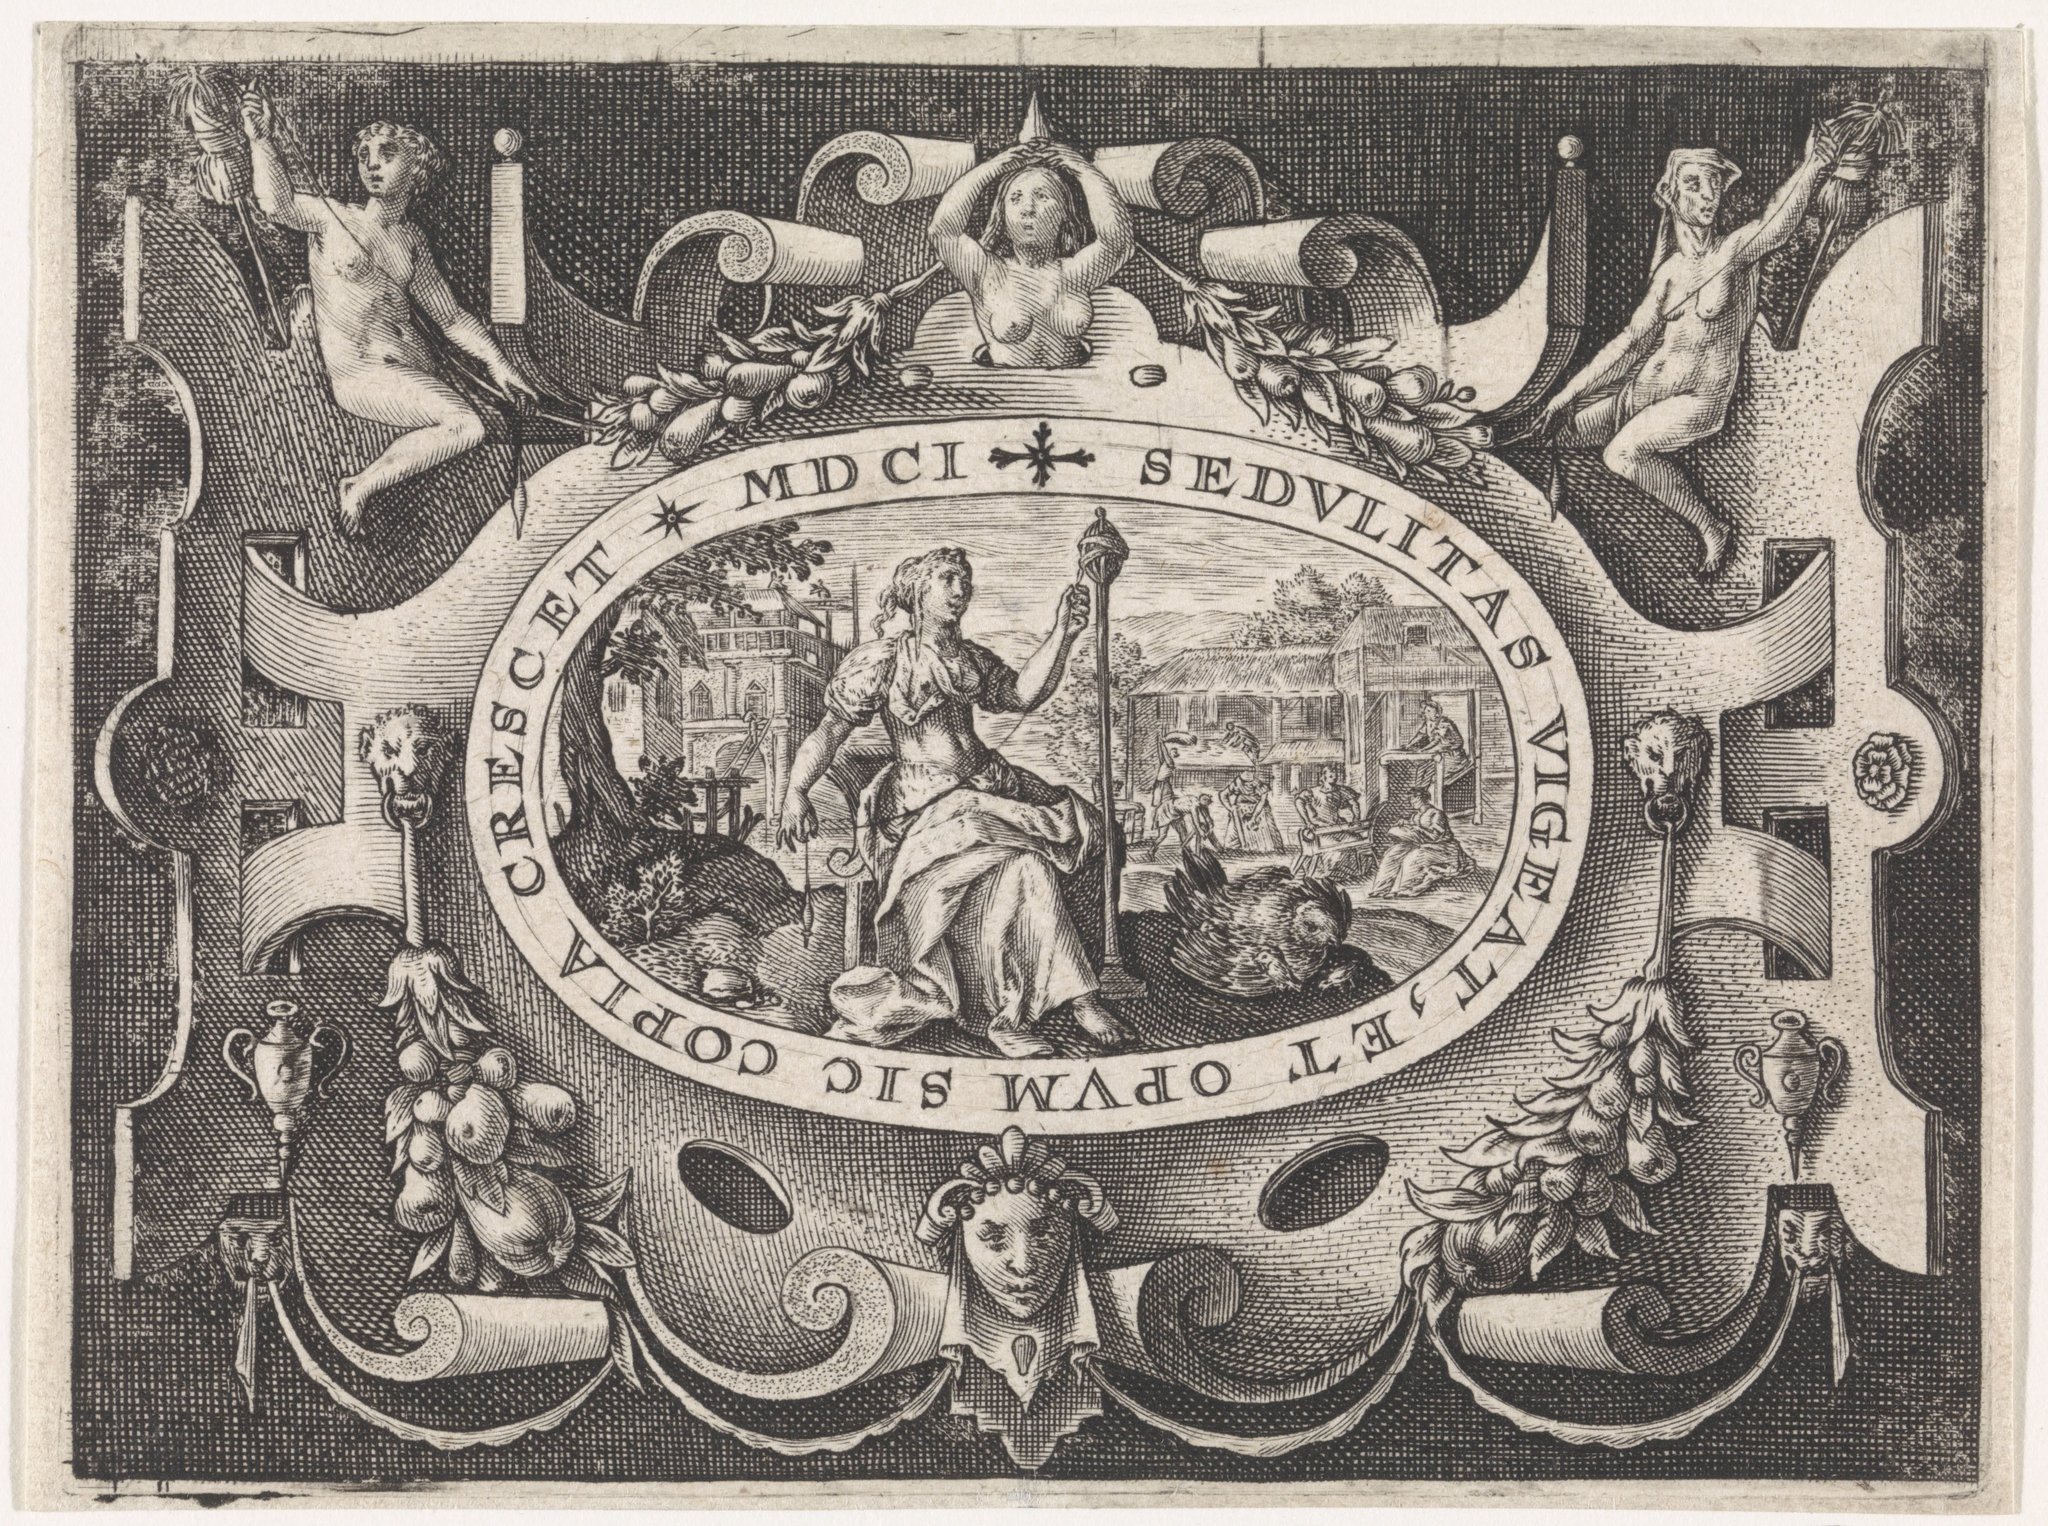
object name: print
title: Kringloop van het menselijk handelen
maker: crispijn van de passe (i)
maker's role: draughtsman, print maker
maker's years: 1564-1637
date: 1601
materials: paper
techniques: engraving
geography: cologne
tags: carefulness, diligence; 'diligenza' (ripa)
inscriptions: collector's mark: Lugt 2228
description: De vrouwelijke personificatie van Arbeidzaamheid (Sedulitas), met een spinrokken. Ze wordt vergezeld door een kip met kuikens, die symbool staan voor vlijtig werken. Op de achtergrond zijn vrouwen vlijtig aan het weven en spinnen. De voorstelling heeft een omlijsting met een randschrift in het Latijn die is gevat in een rijk gedecoreerd cartouche. Eerste prent uit een serie van acht met de kringloop van het menselijk handelen.